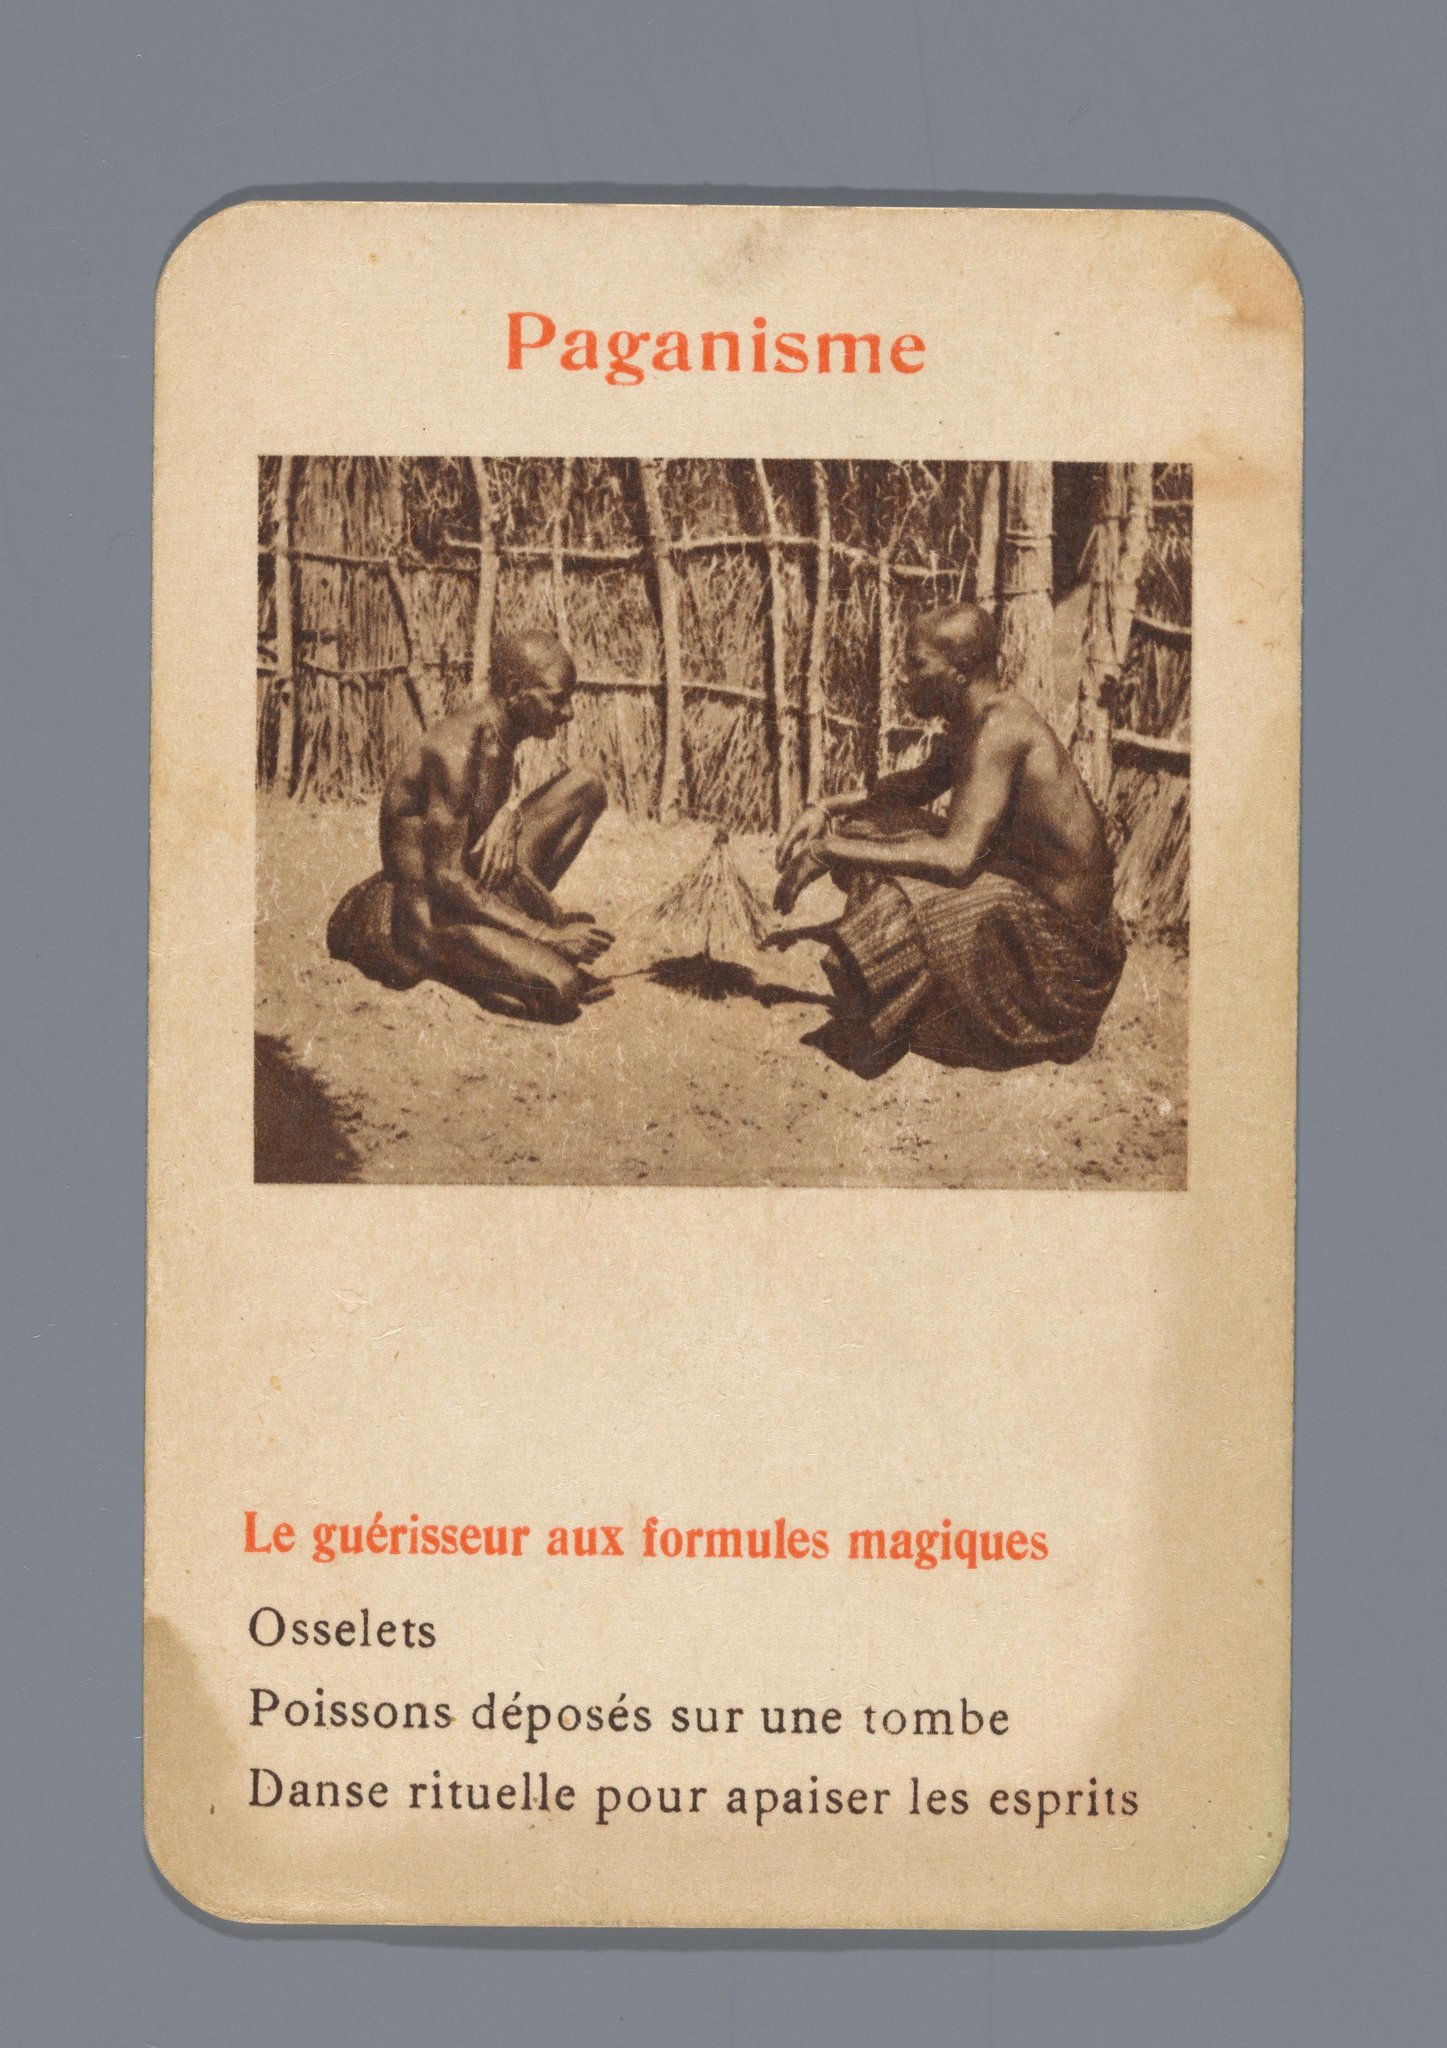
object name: card game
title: Priester of natuurgenezer zittend op de grond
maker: Anonymous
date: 1900-1920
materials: cardboard, paper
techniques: rotogravure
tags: african traditional religions, card games